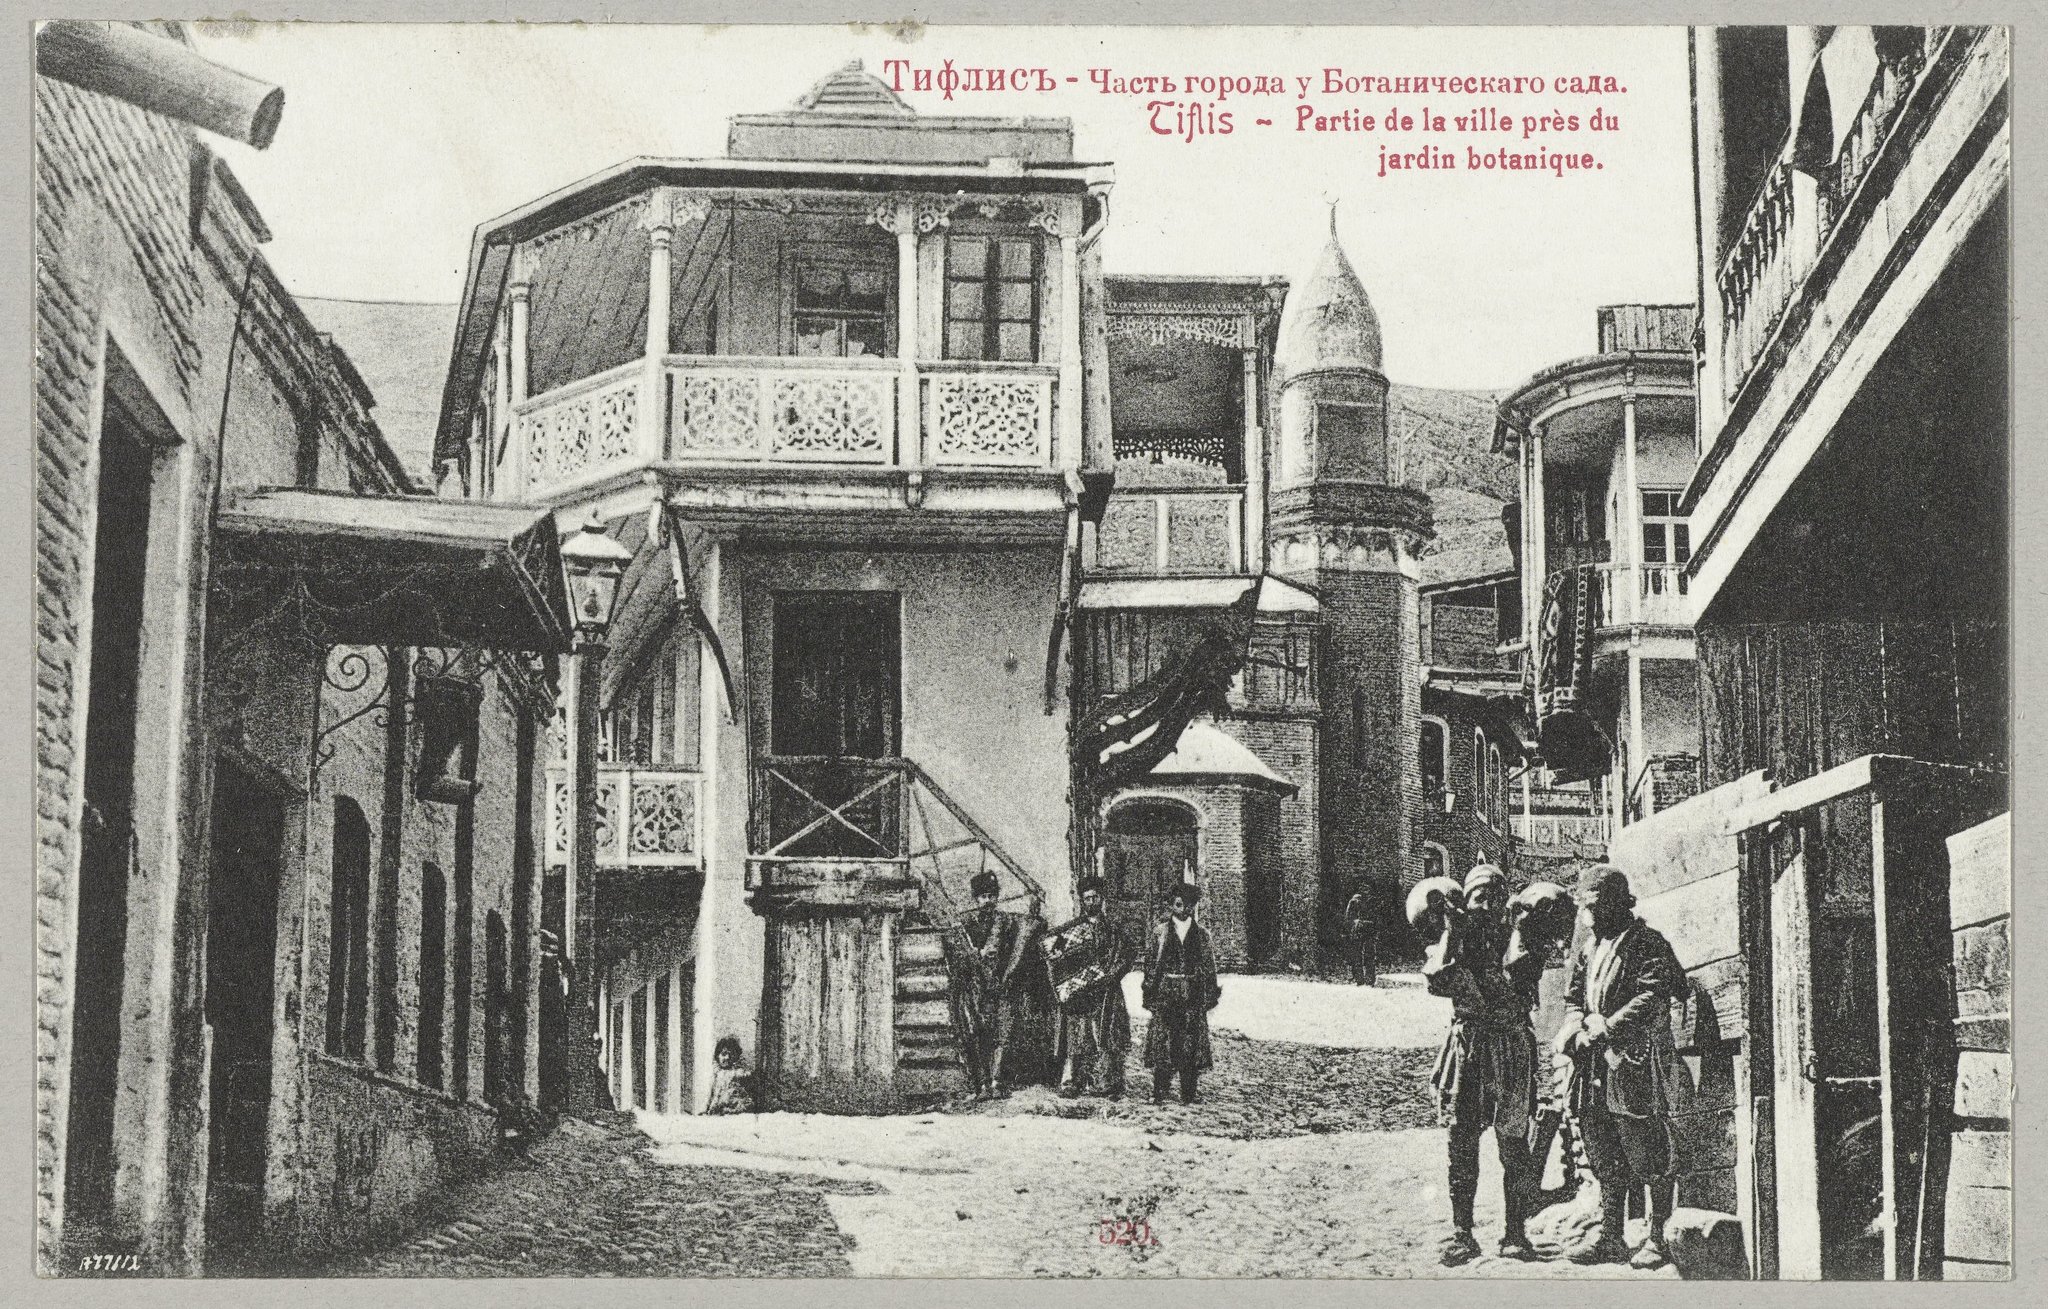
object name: photomechanical print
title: Gedeelte van de stad Tiflis nabij de botanische tuin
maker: Anonymous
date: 1895-1915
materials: cardboard, paper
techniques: photograph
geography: tbilisi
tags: tbilisi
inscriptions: number: ‘30.’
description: Bovenaan staat de Oezbeekse titel boven de Franse titel, linksonder staat: A77112 en midden onder: 520.